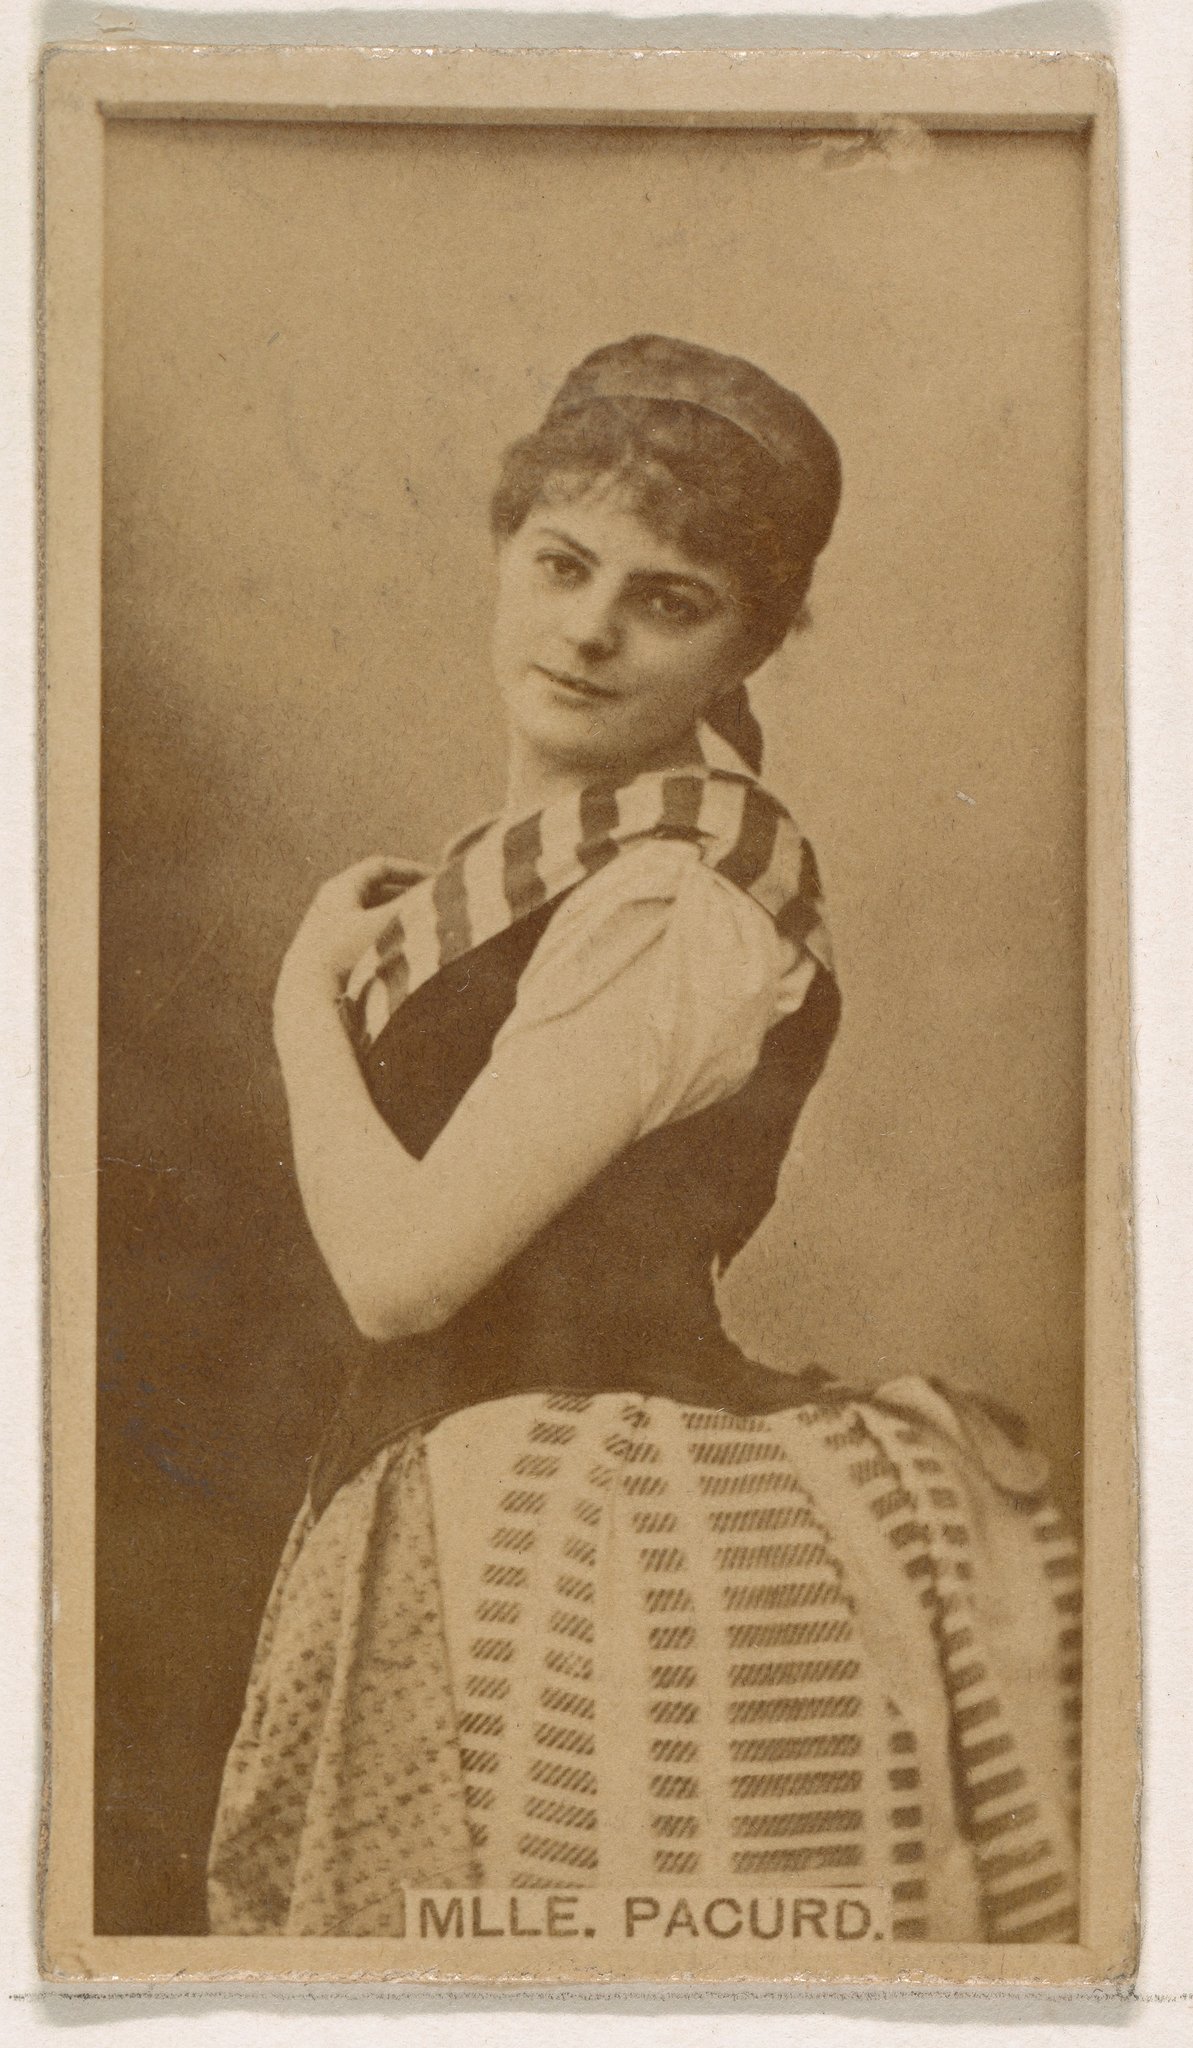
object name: photograph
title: Mlle. Pacurd, from the Actresses series (N245) issued by Kinney Brothers to promote Sweet Caporal Cigarettes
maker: kinney brothers tobacco company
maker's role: publisher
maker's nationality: american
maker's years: 1869-2011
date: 1890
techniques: albumen silver print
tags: portraits,women,actresses